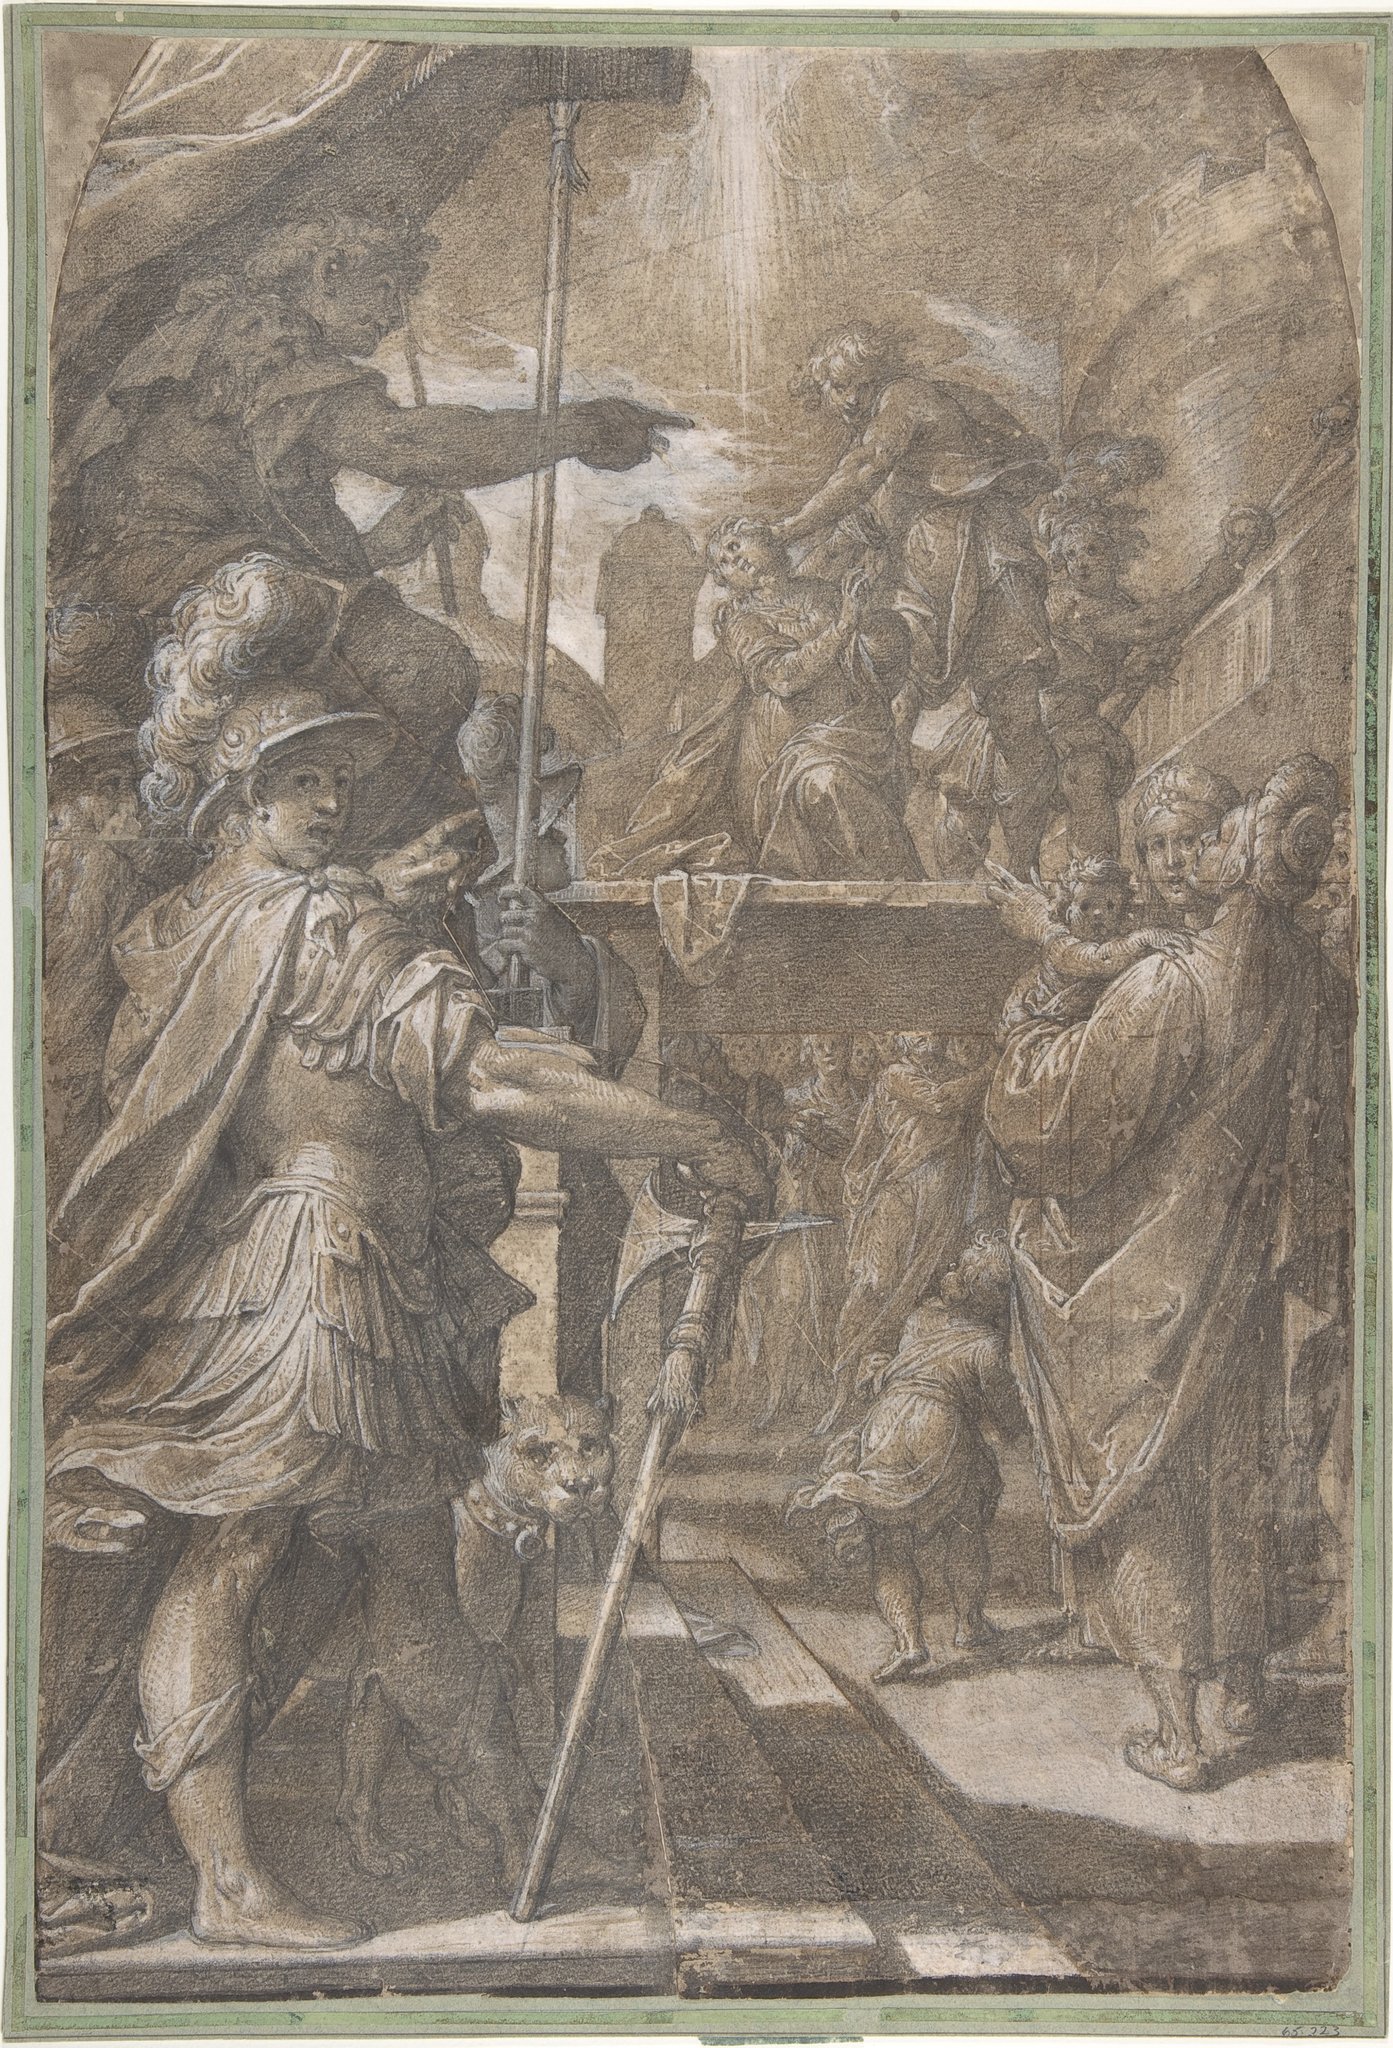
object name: drawing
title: Martyrdom of a Female Saint (Agnes?)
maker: camillo procaccini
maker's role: artist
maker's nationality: italian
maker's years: 1555-1629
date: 1605-1609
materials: charcoal, gouache, ink, paper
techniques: brush, highlighting, pen, wash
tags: animals,spears,infants,women,saints